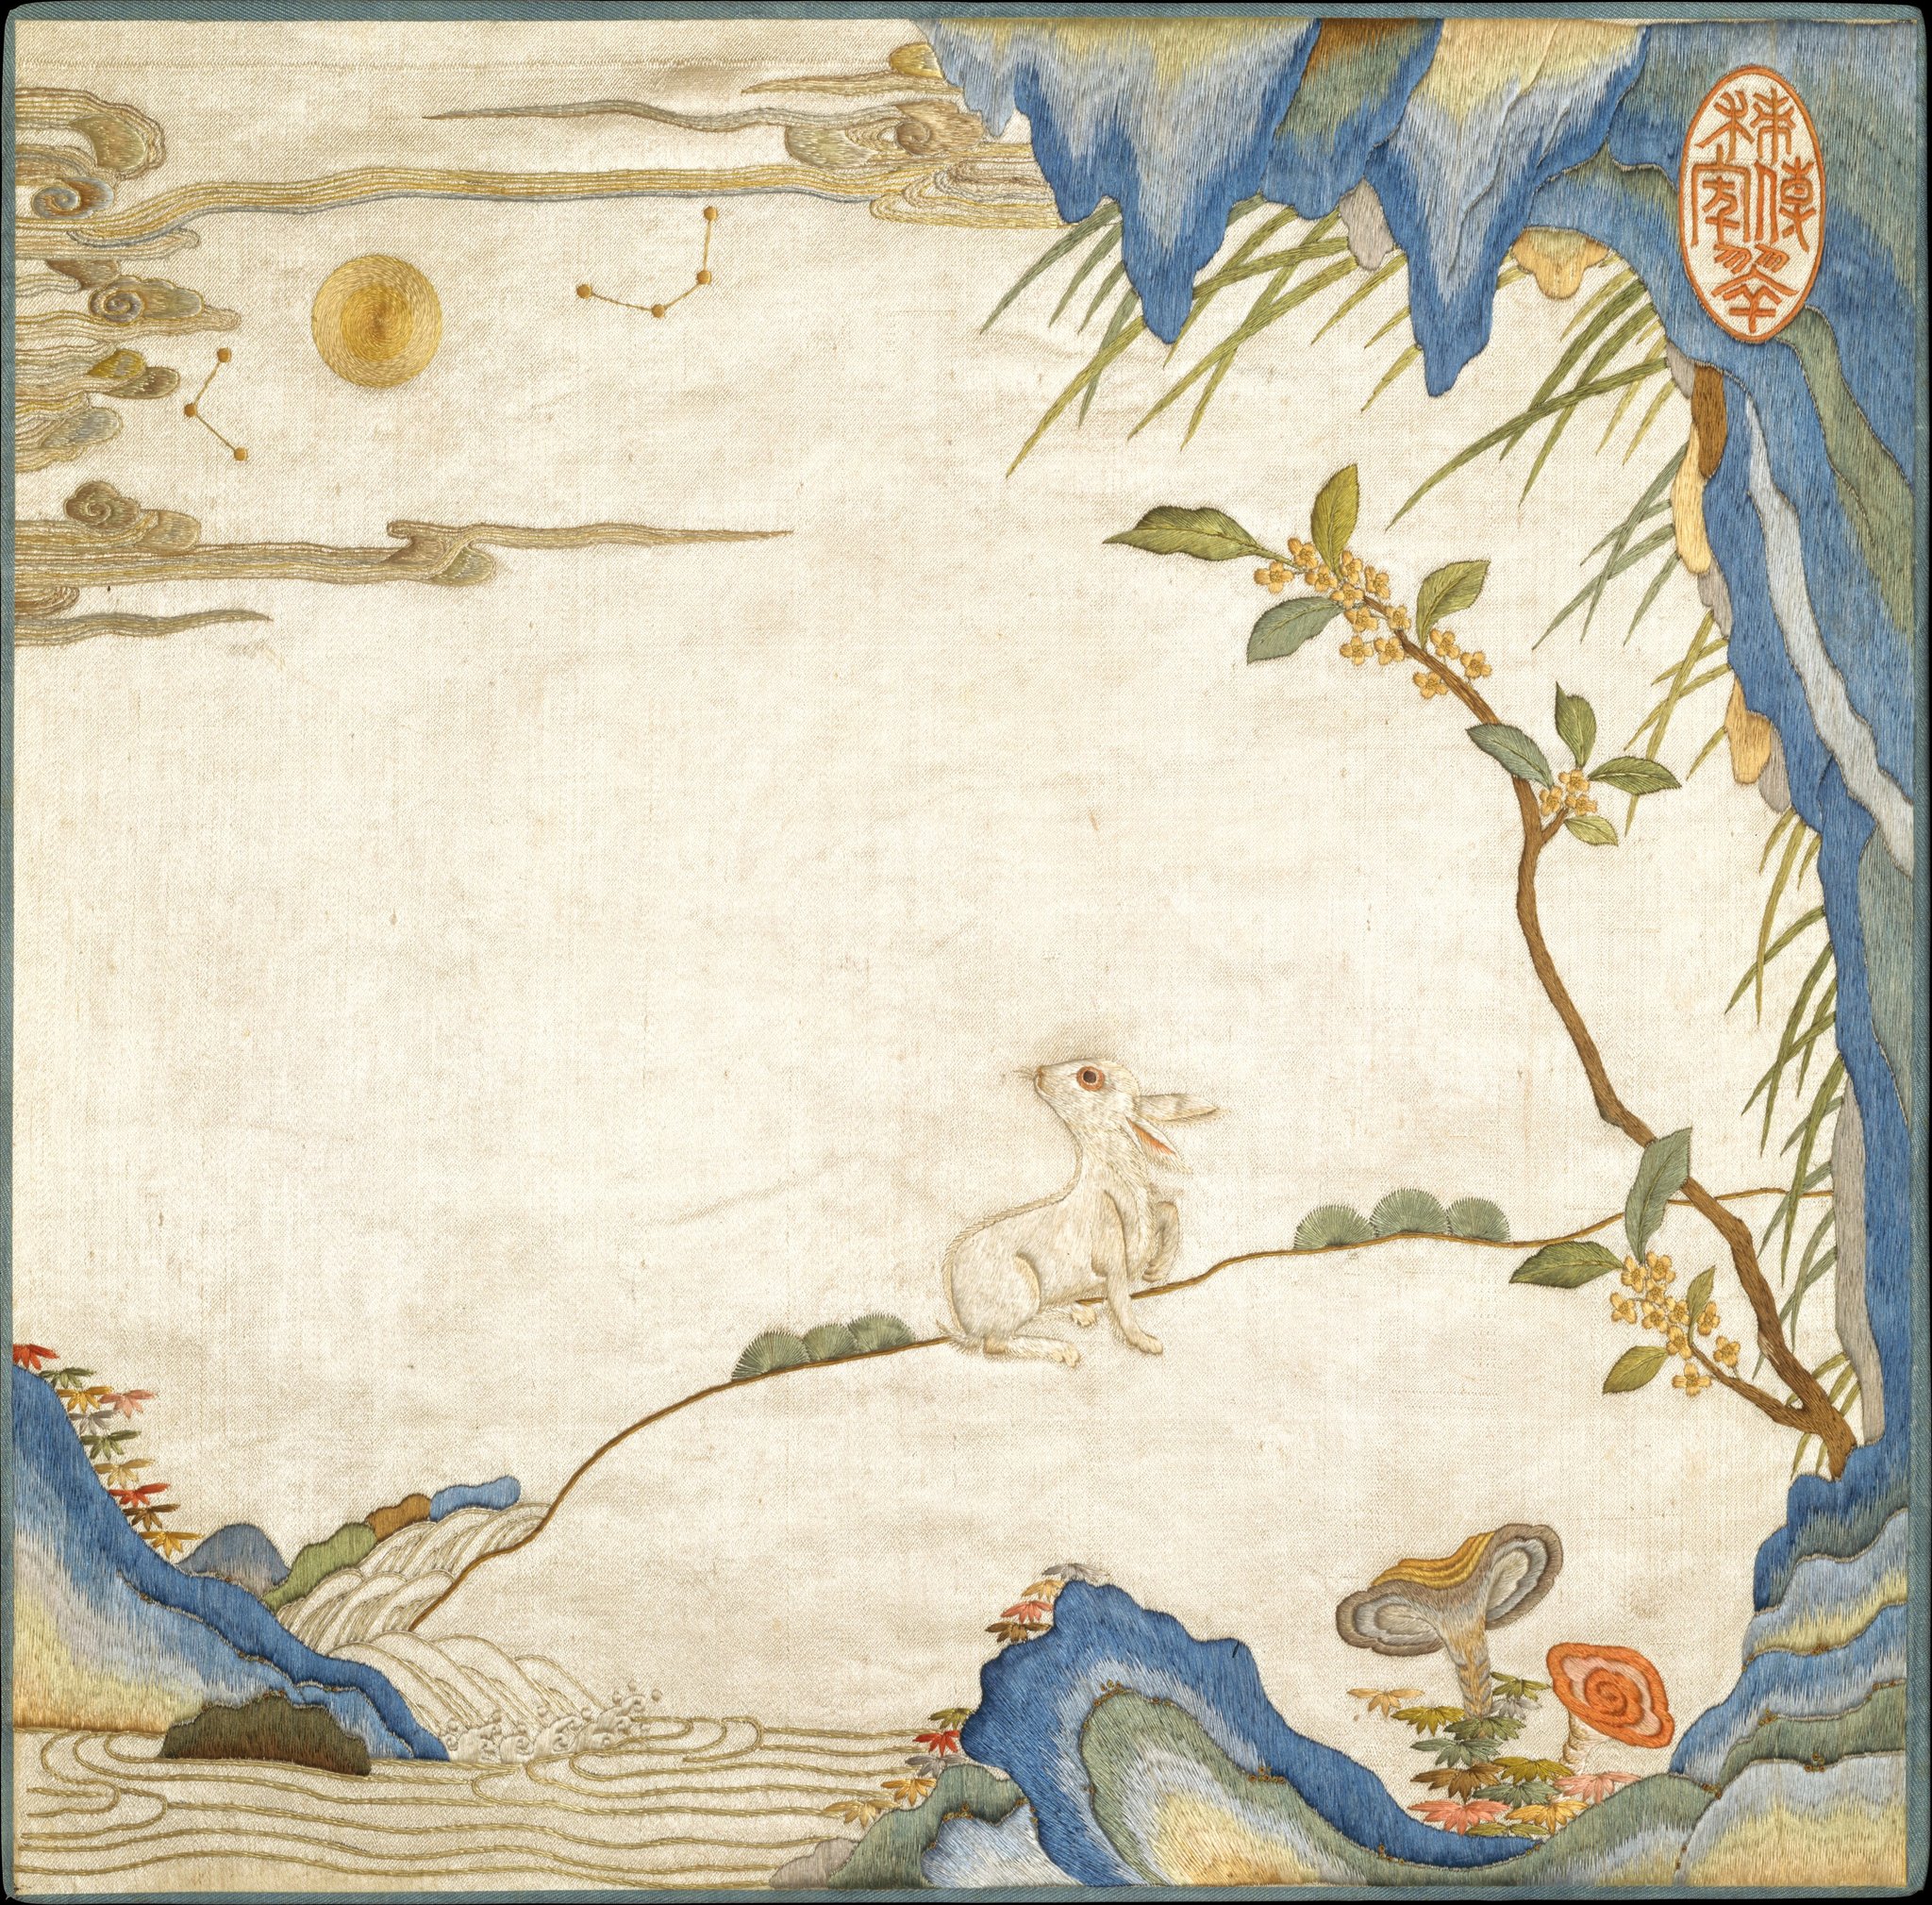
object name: panel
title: Rabbit gazing at the moon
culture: chinese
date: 1701-1800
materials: silk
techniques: embroidery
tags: rabbits,moon,landscapes,plants